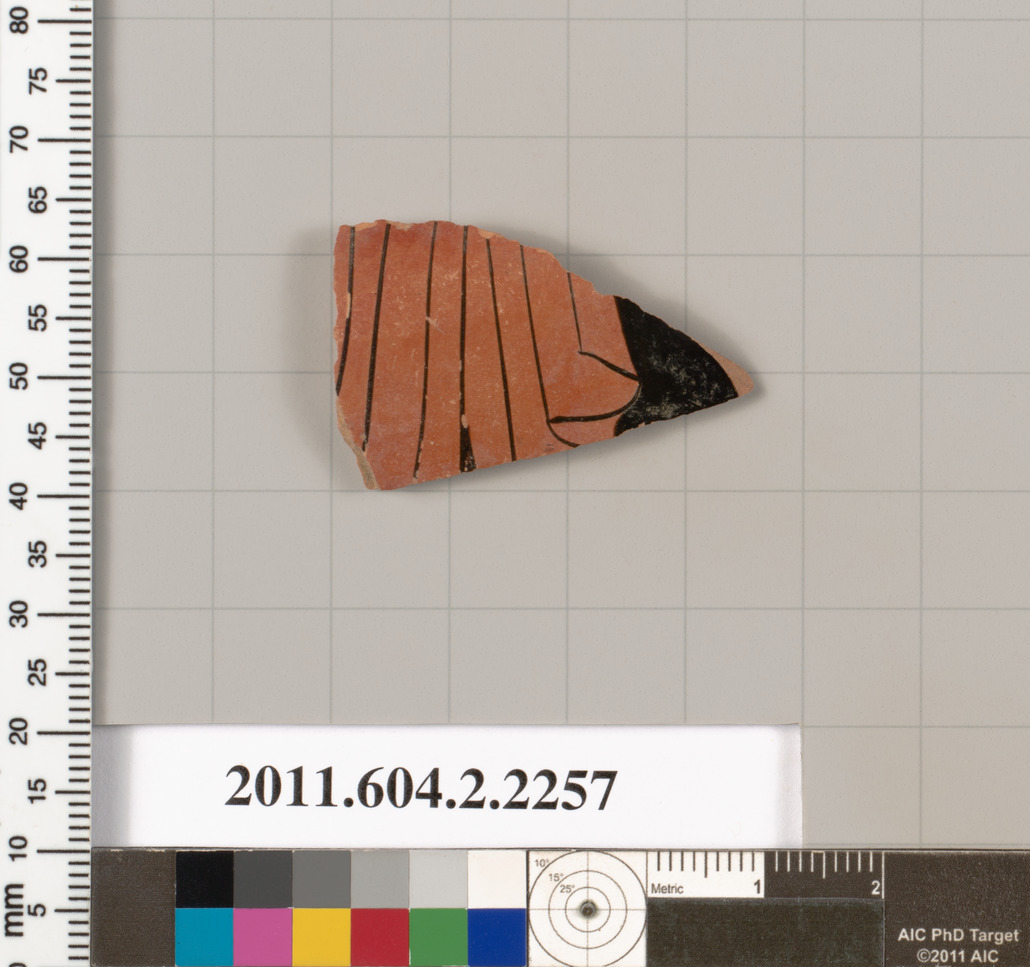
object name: pot fragment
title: Terracotta fragment of a pot; unglazed on the inside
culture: greek, attic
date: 475-451 BCE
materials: terracotta